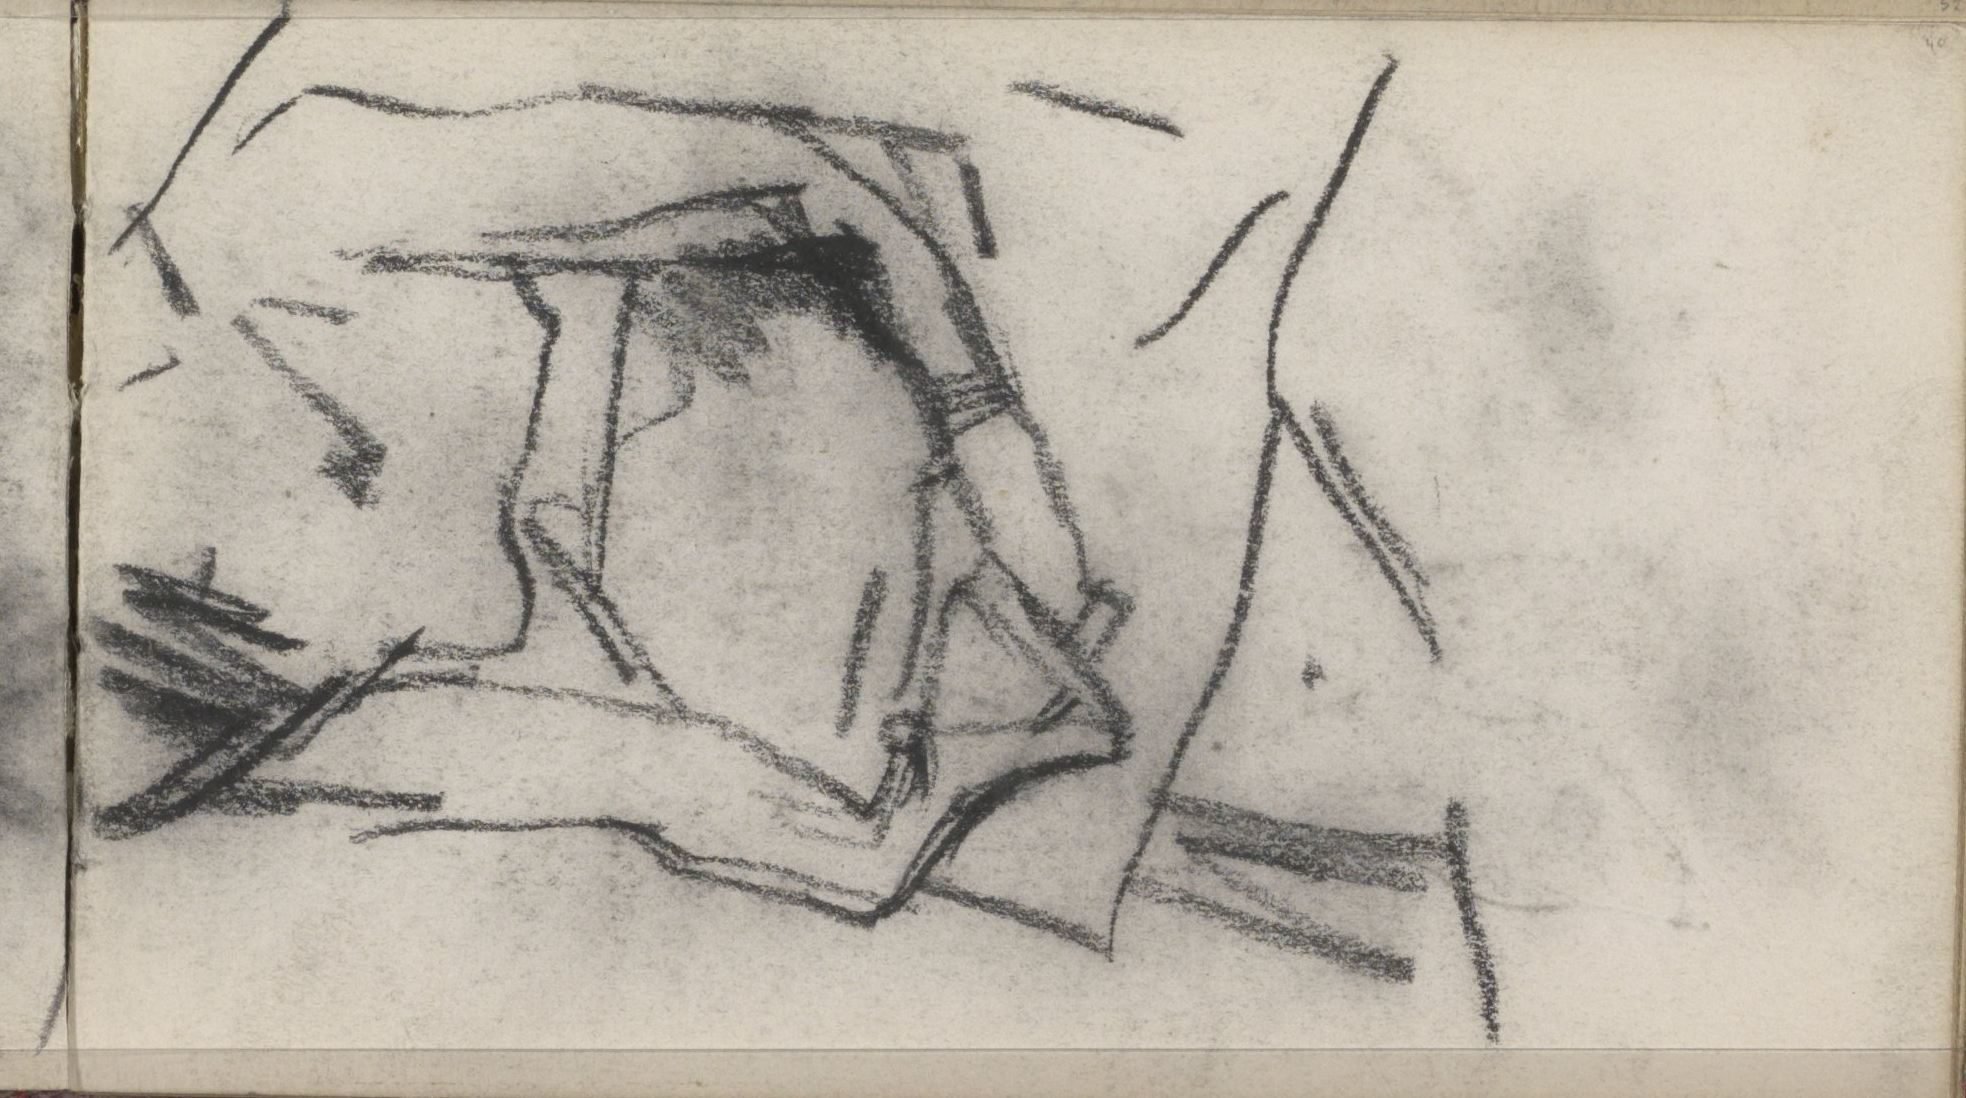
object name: sketchbook leaf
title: Zittende vrouw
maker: george hendrik breitner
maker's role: draughtsman, painter, print maker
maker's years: 1857-1923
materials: chalk, paper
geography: amsterdam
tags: sitting figure - aa - female human figure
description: Haar ellebogen rusten op haar knieën. Pagina 40 uit een schetsboek met 32 bladen.